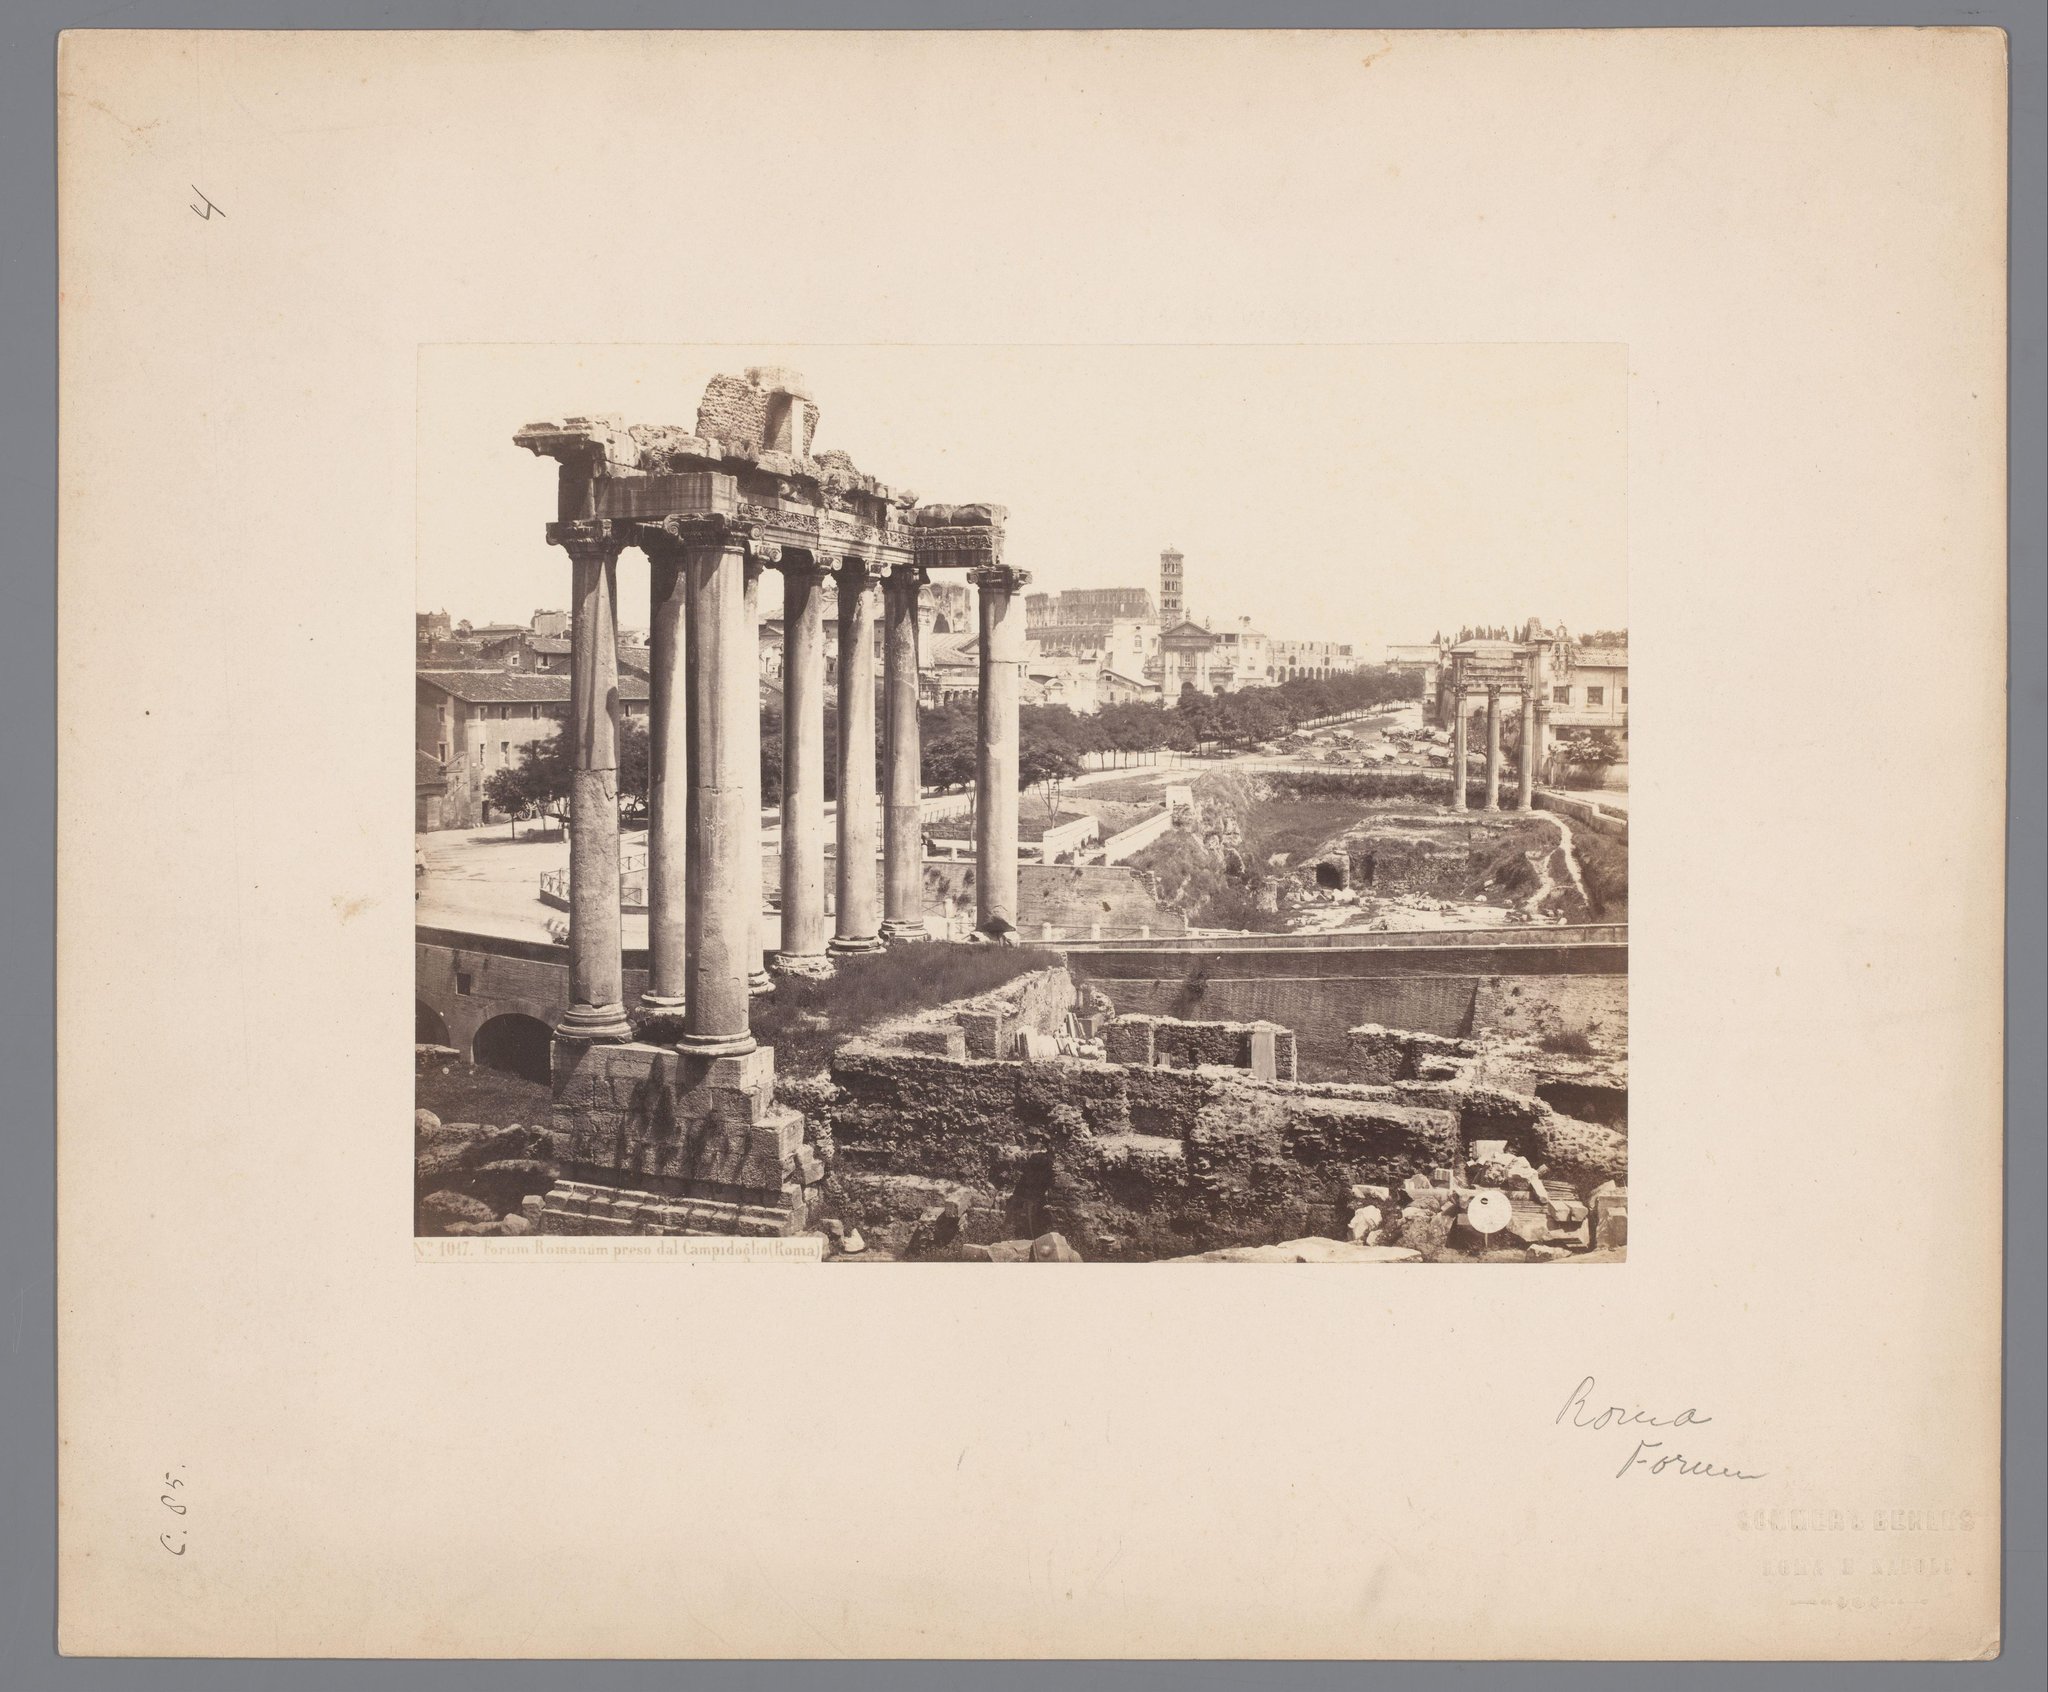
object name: photograph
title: Ruïnes op het Forum Romanum te Rome, Italië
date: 1867-1874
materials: cardboard, paper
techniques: albumen print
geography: rome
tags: square, place, circus, etc., ruin of a building ~ architecture, landscape with ruins, rome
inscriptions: number: ‘4’, address: ‘SOMMER & BEHLES/ ROMA E NAPOLI’, number: ‘No. 1017.’, inscription: ‘C. 85’, inscription: ‘Roma/ Forum’